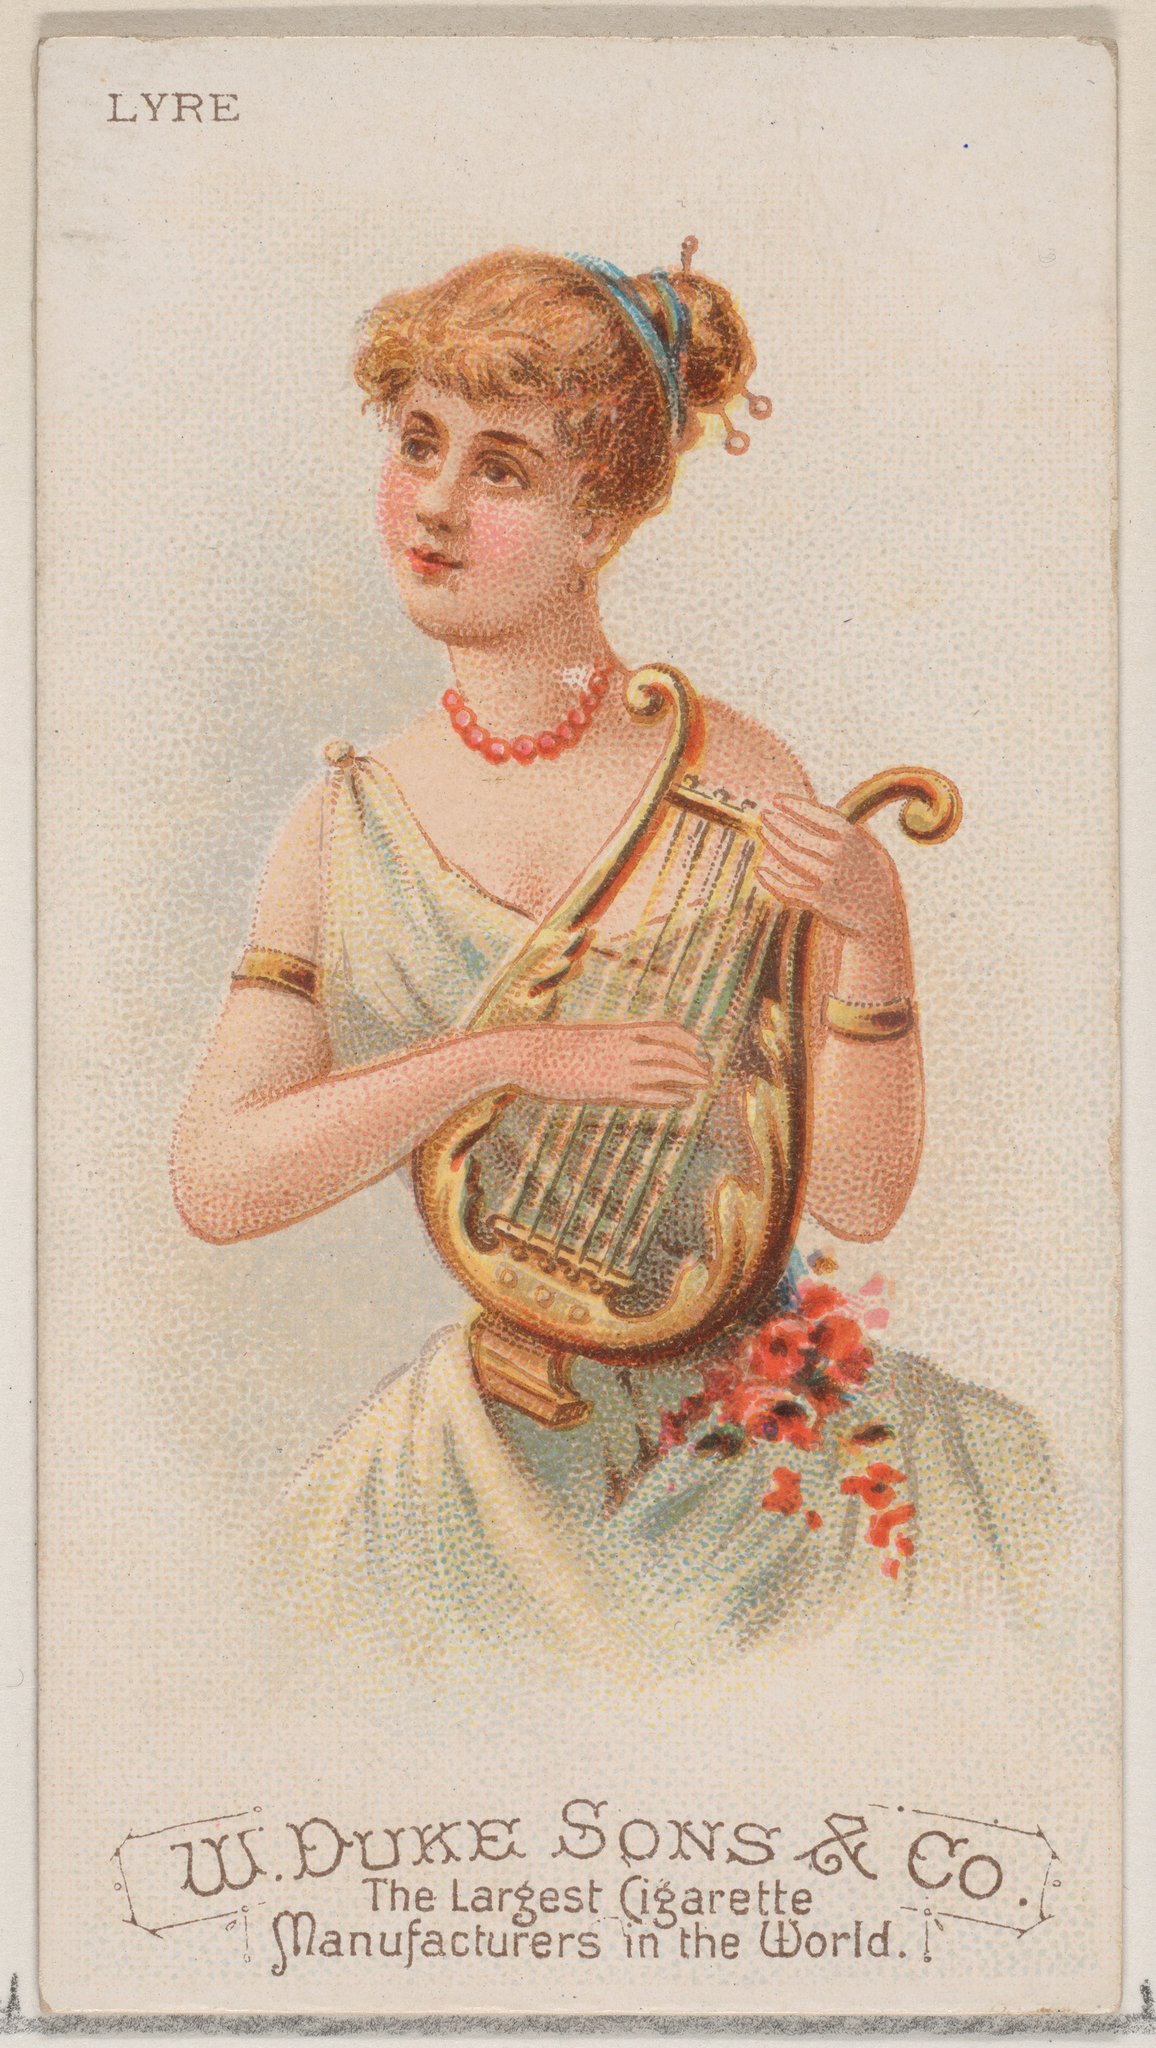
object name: print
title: Lyre, from the Musical Instruments series (N82) for Duke brand cigarettes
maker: w. duke, sons & co.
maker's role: publisher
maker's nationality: american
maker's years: 1870-1920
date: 1888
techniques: color lithograph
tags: musical instruments,women,musicians